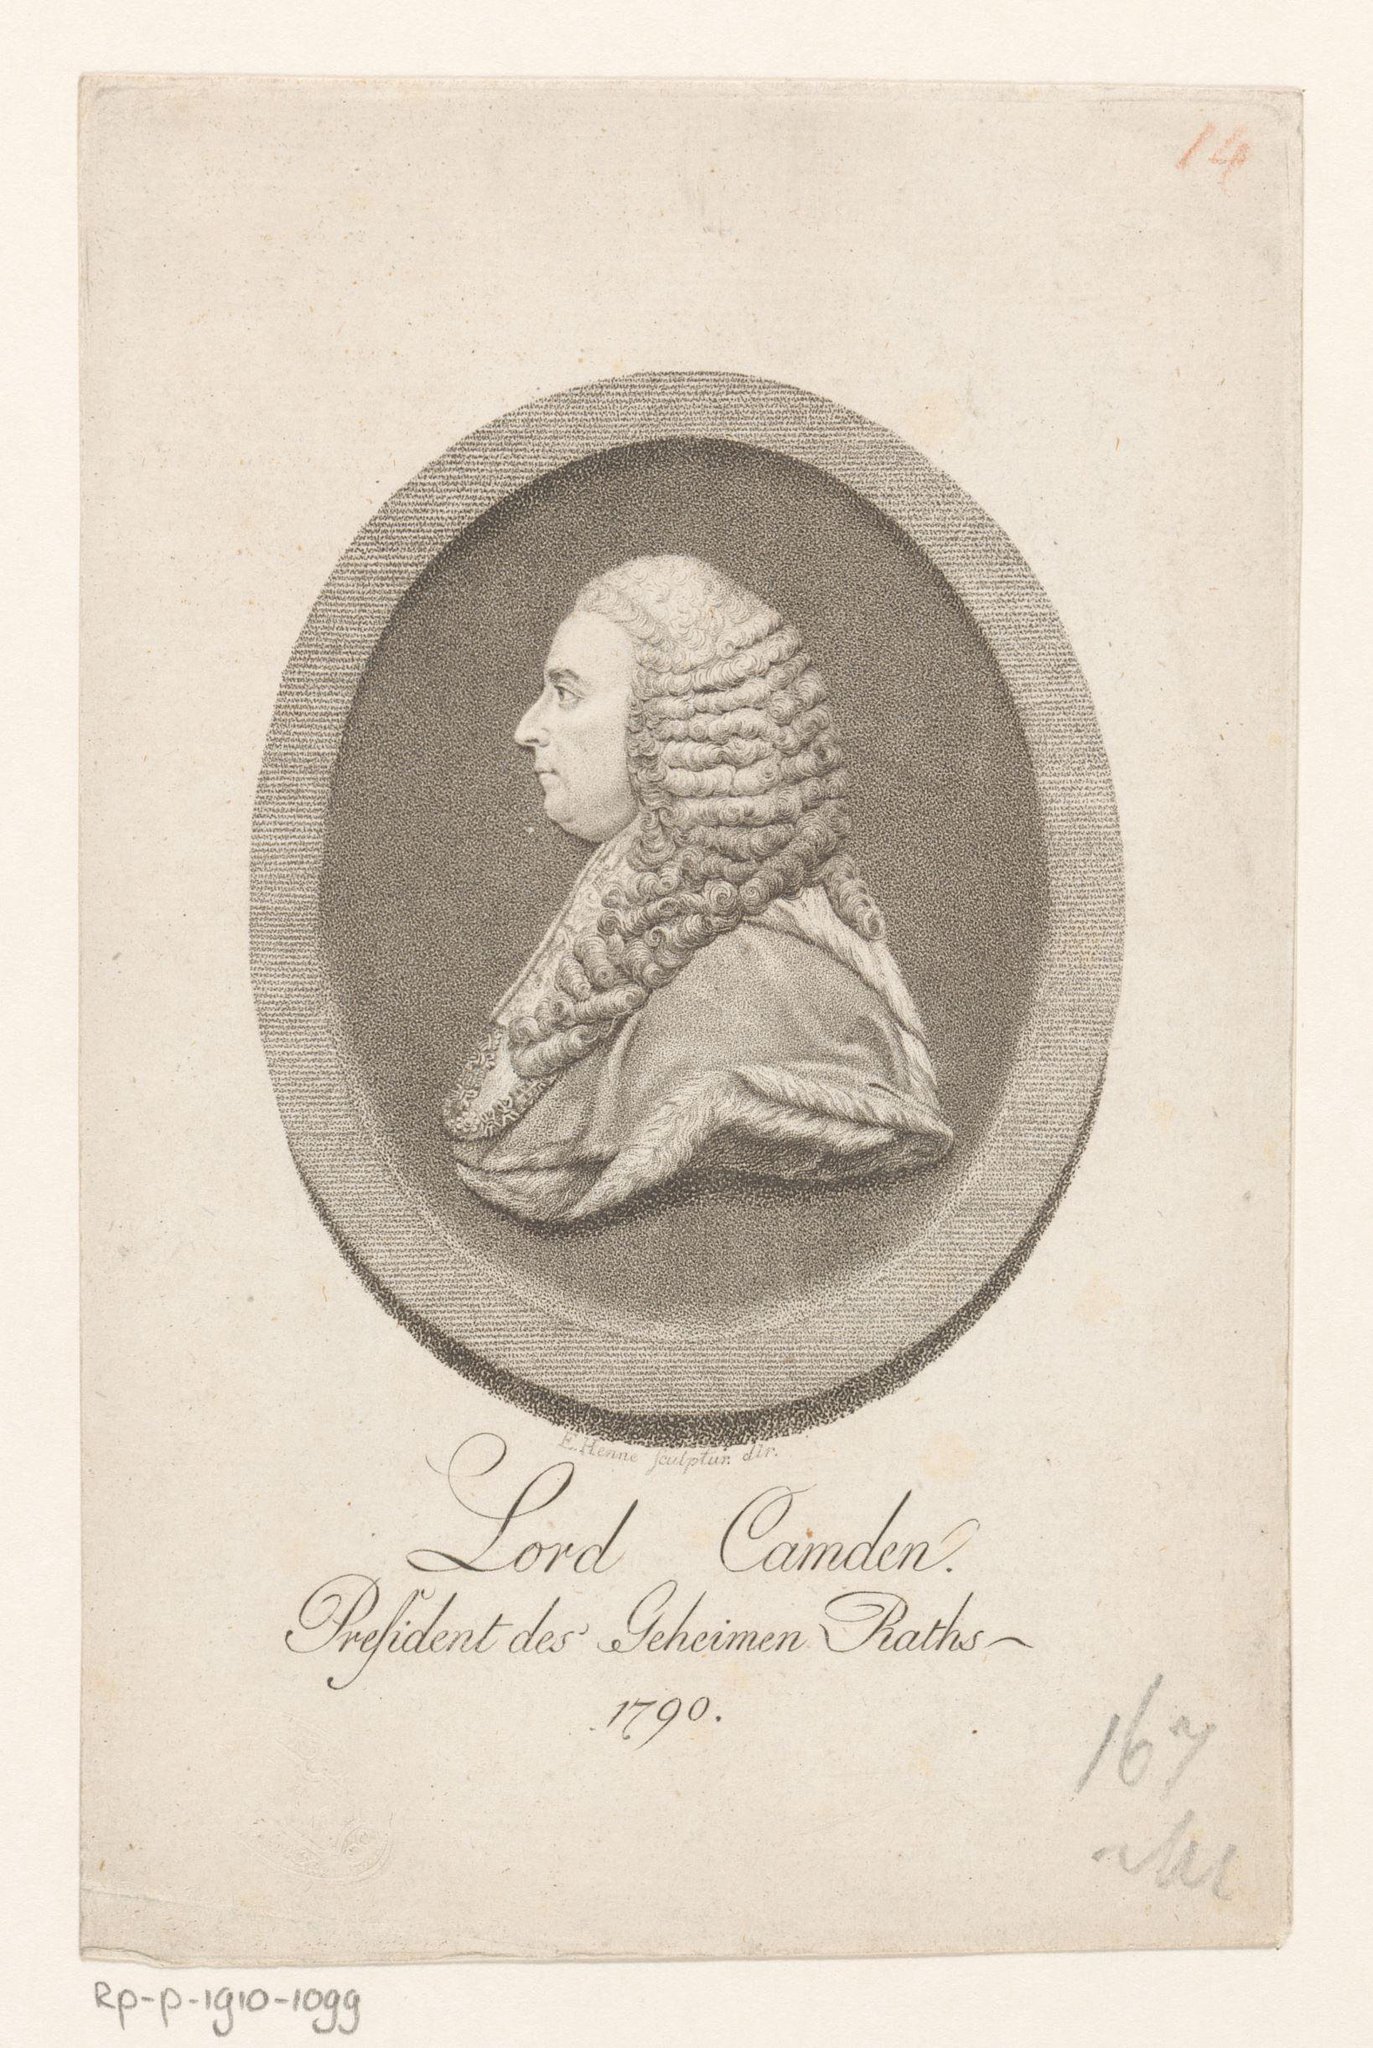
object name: print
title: Portret van Adolph Albrecht Heinrich Leopold von Danckelmann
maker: eberhard siegfried henne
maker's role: print maker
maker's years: 1759-1828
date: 1769-1828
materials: paper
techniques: engraving, etching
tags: historical persons, armorial bearing, heraldry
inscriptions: collector's mark: Lugt 2228